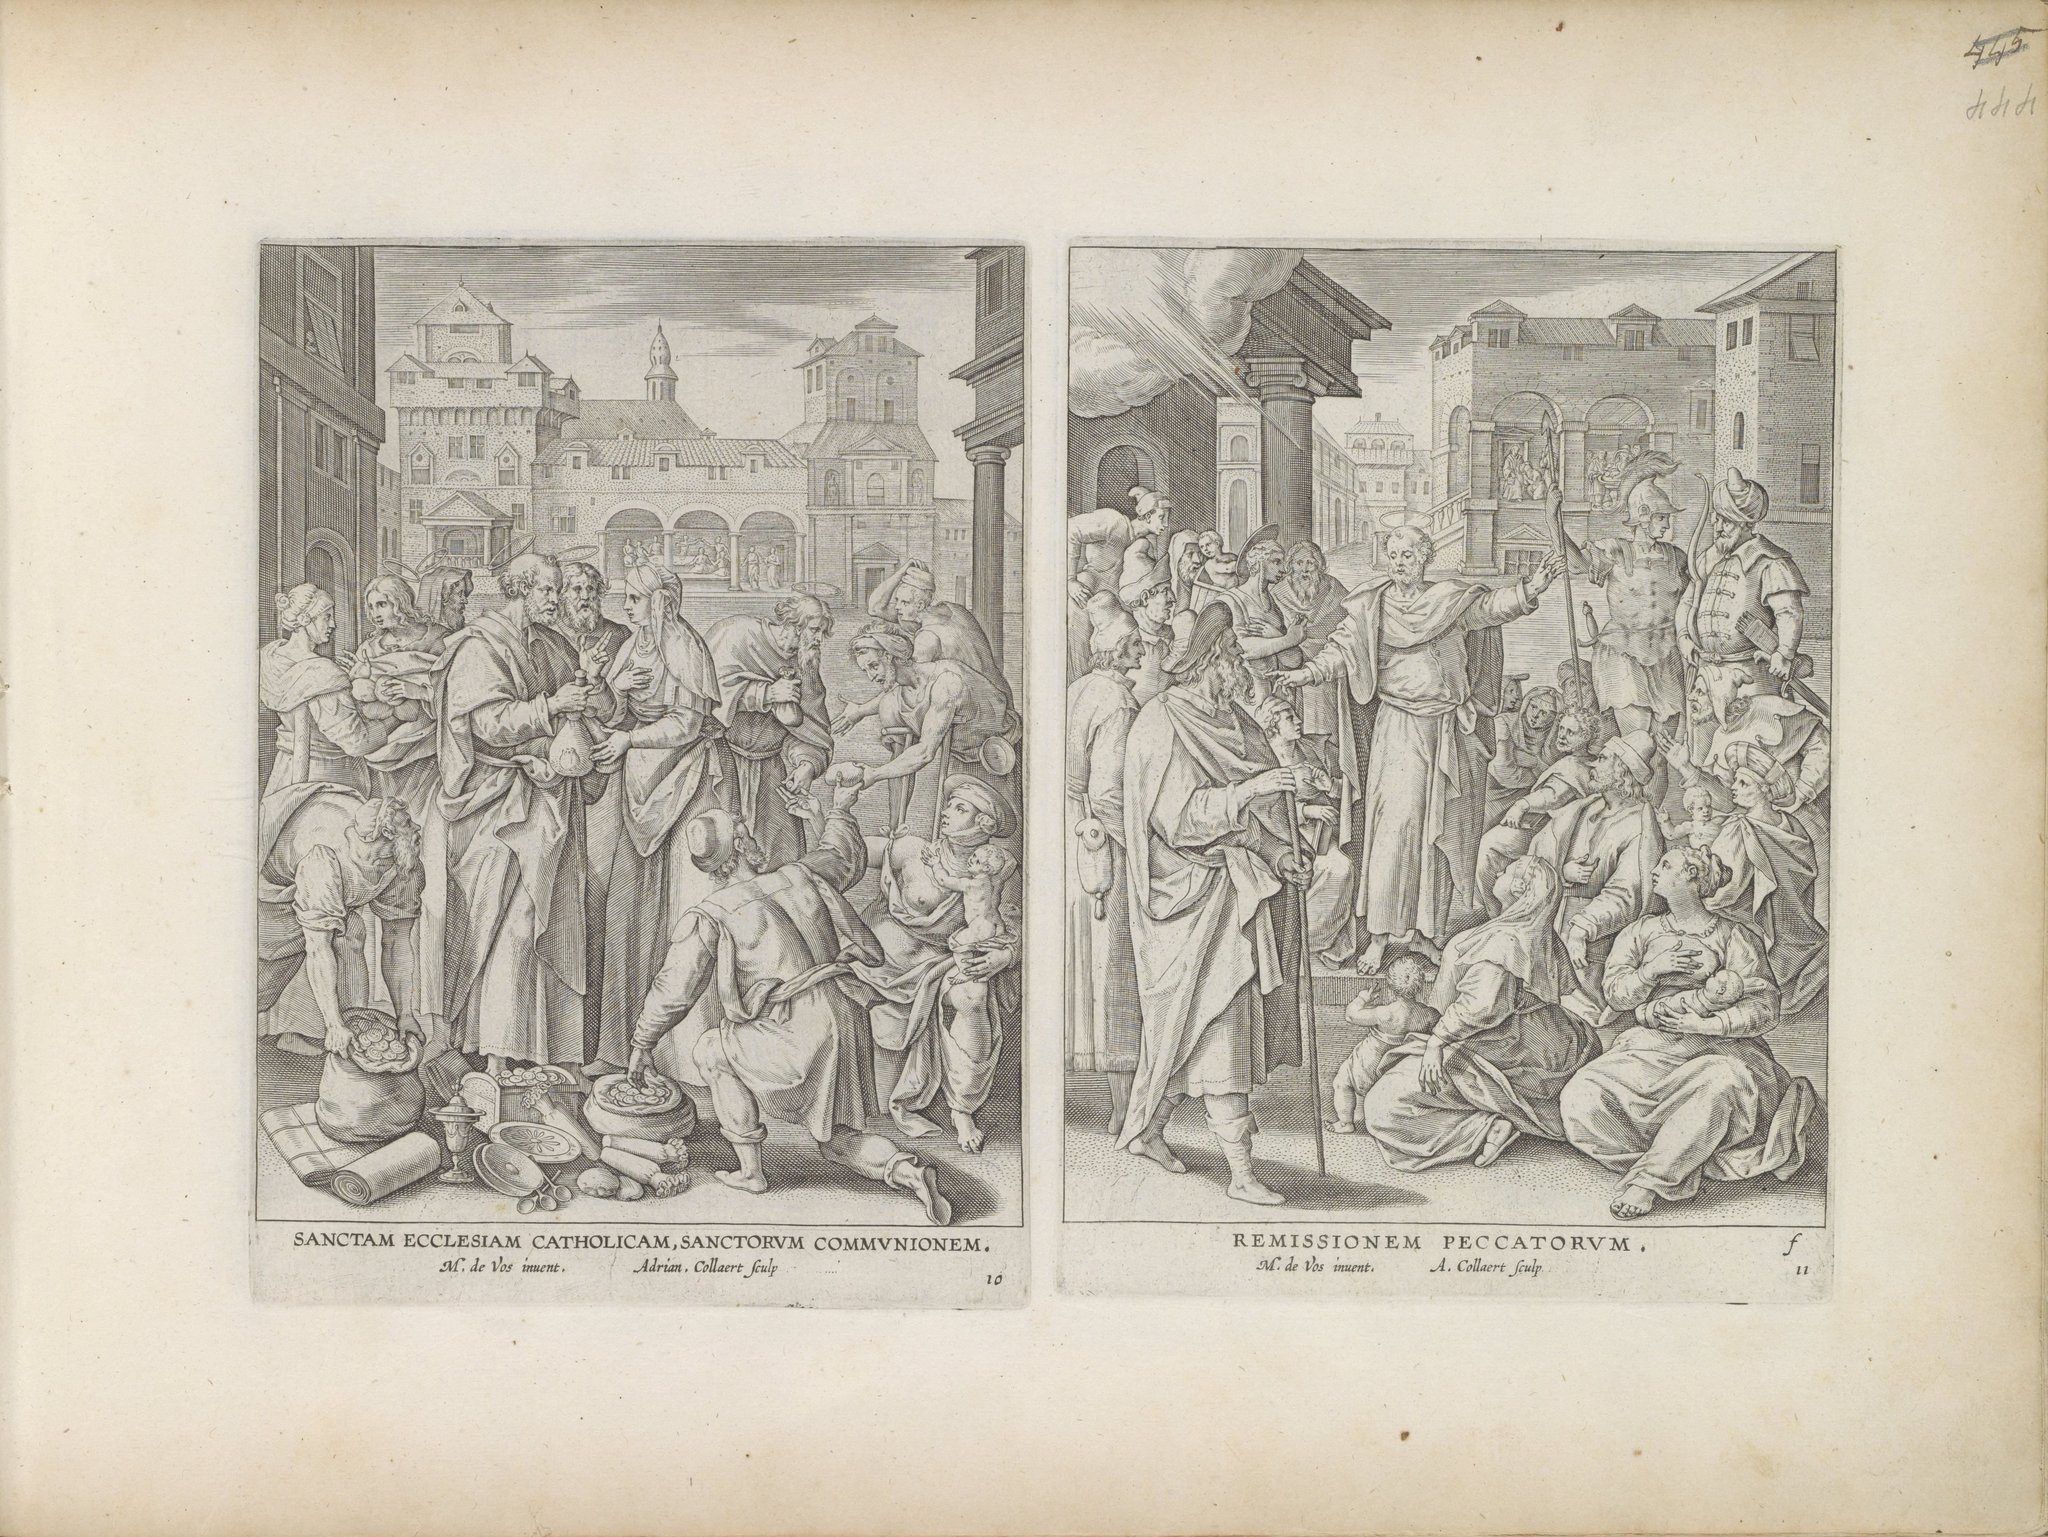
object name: album leaf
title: Sanctam ecclesiam catholicam sanctorum communionem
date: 1570-1618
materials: paper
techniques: engraving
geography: amsterdam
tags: distribution of gifts by christ's disciples to every man according to his needs, disciples live sharing their goods communally, 'sanctam ecclesiam catholicam, sanctuorum communionem' ~ articles of faith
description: Illustratie van het negende geloofsartikel (de heilige katholieke Kerk, de gemeenschap van de heiligen) van de apostolische geloofsbelijdenis. De apostelen ontvangen van andere gelovigen geld, dat ze uitdelen aan de mensen die het nodig hebben. Op de grond liggen allerlei bezittingen. Deze prent maakt deel uit van een album.